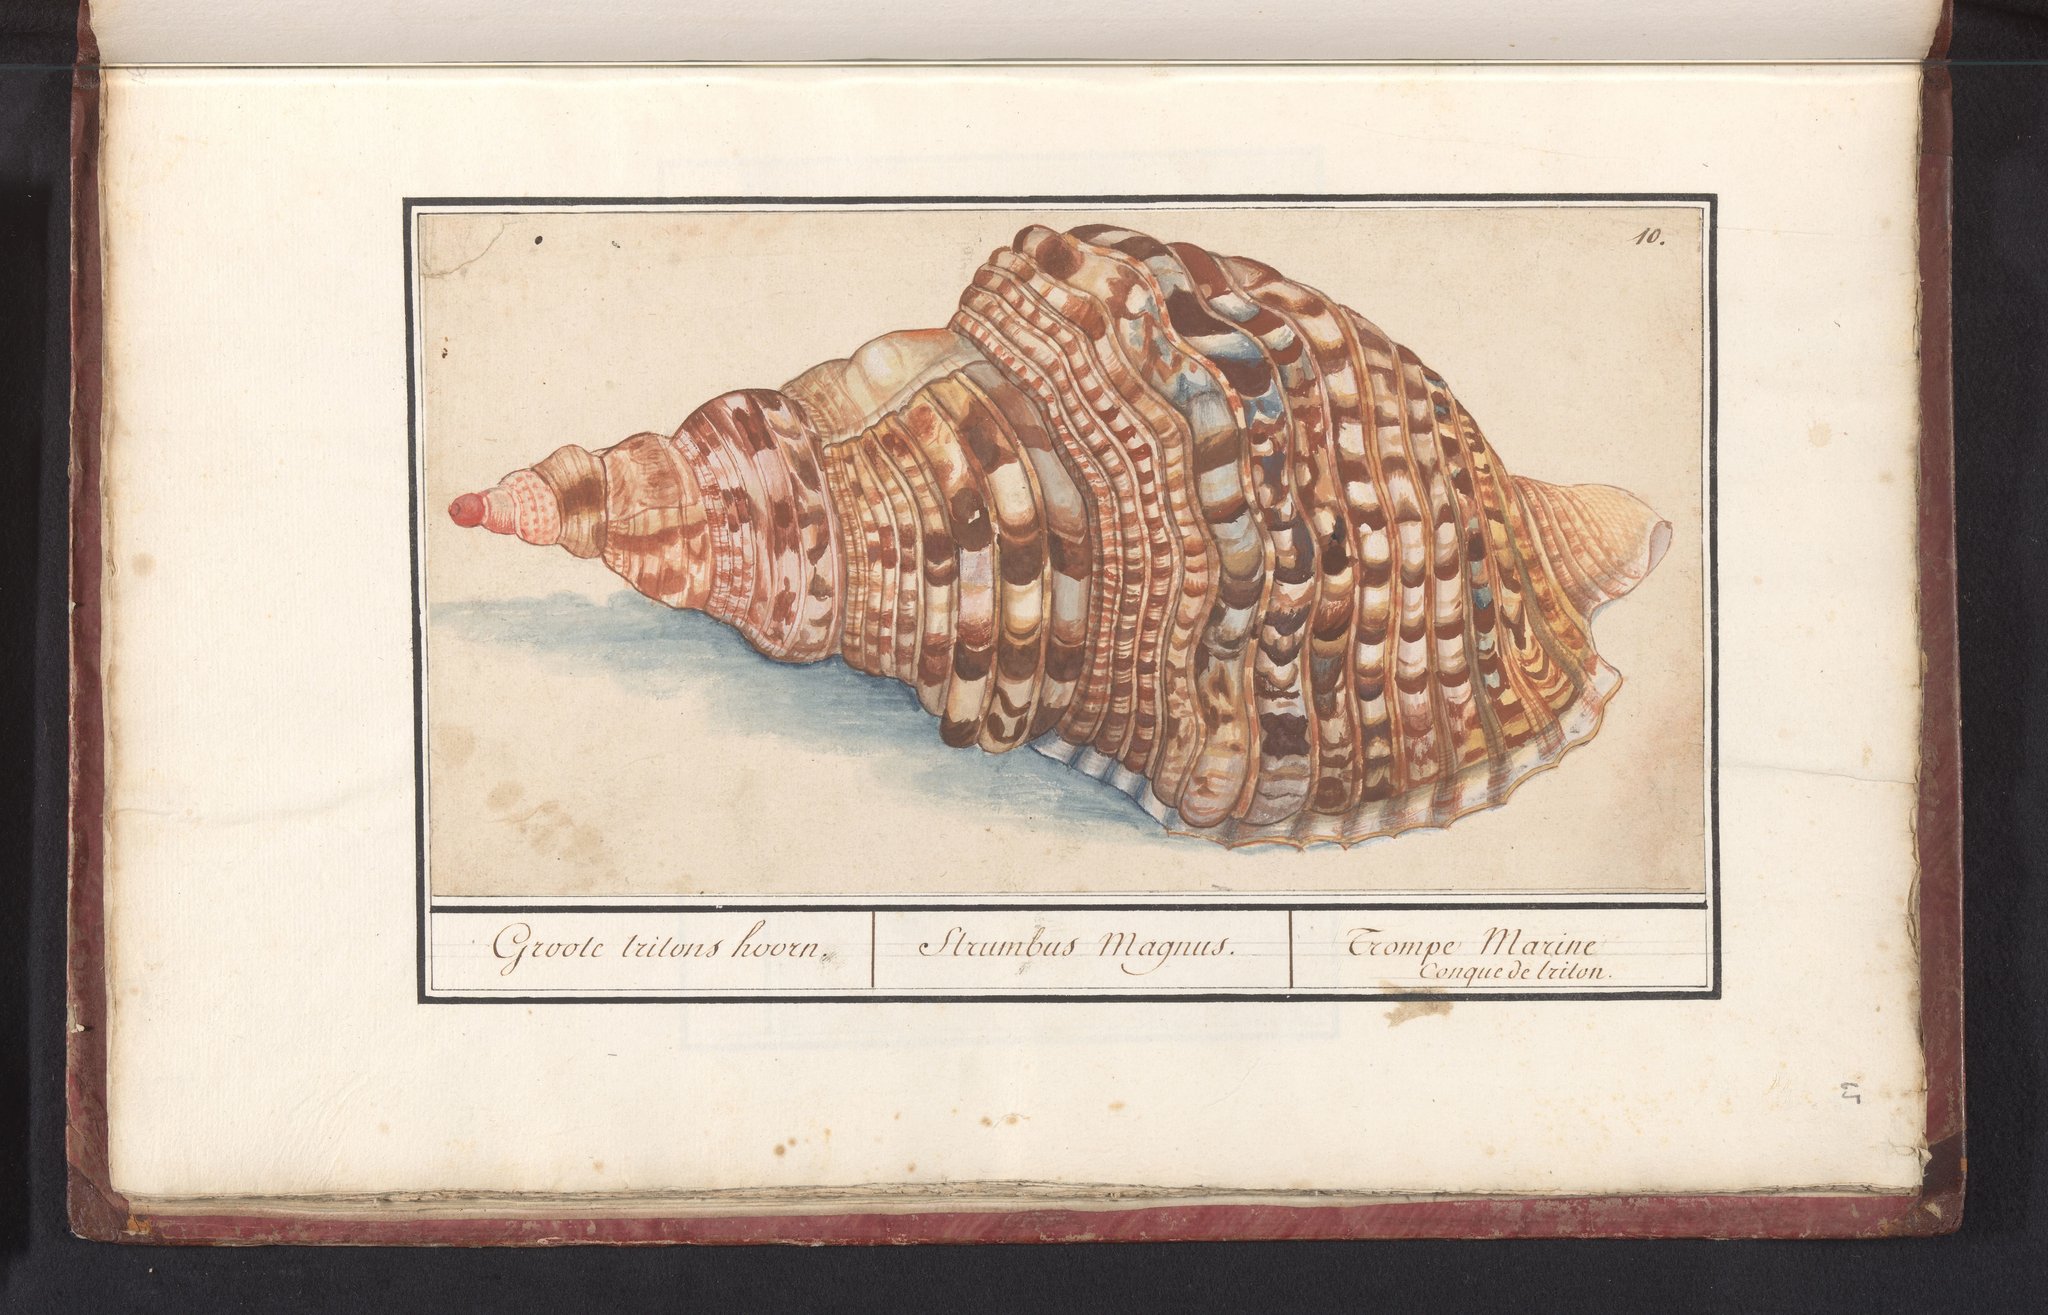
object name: drawing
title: Groote tritons hoorn. / Strumbus Magnus. / Trompe Marine Conque de triton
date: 1596-1610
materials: chalk, paint, paper, pencil, watercolor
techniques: brush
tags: molluscs: triton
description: Tritonshoren. Genummerd rechtsboven: 10. Onderdeel van het zesde album met tekeningen van vissen, schelpen en insekten. Zesde van twaalf albums met tekeningen van dieren, vogels en planten bekend rond 1600, gemaakt in opdracht van keizer Rudolf II. Met toelichting in Nederlands, Latijn en Frans.